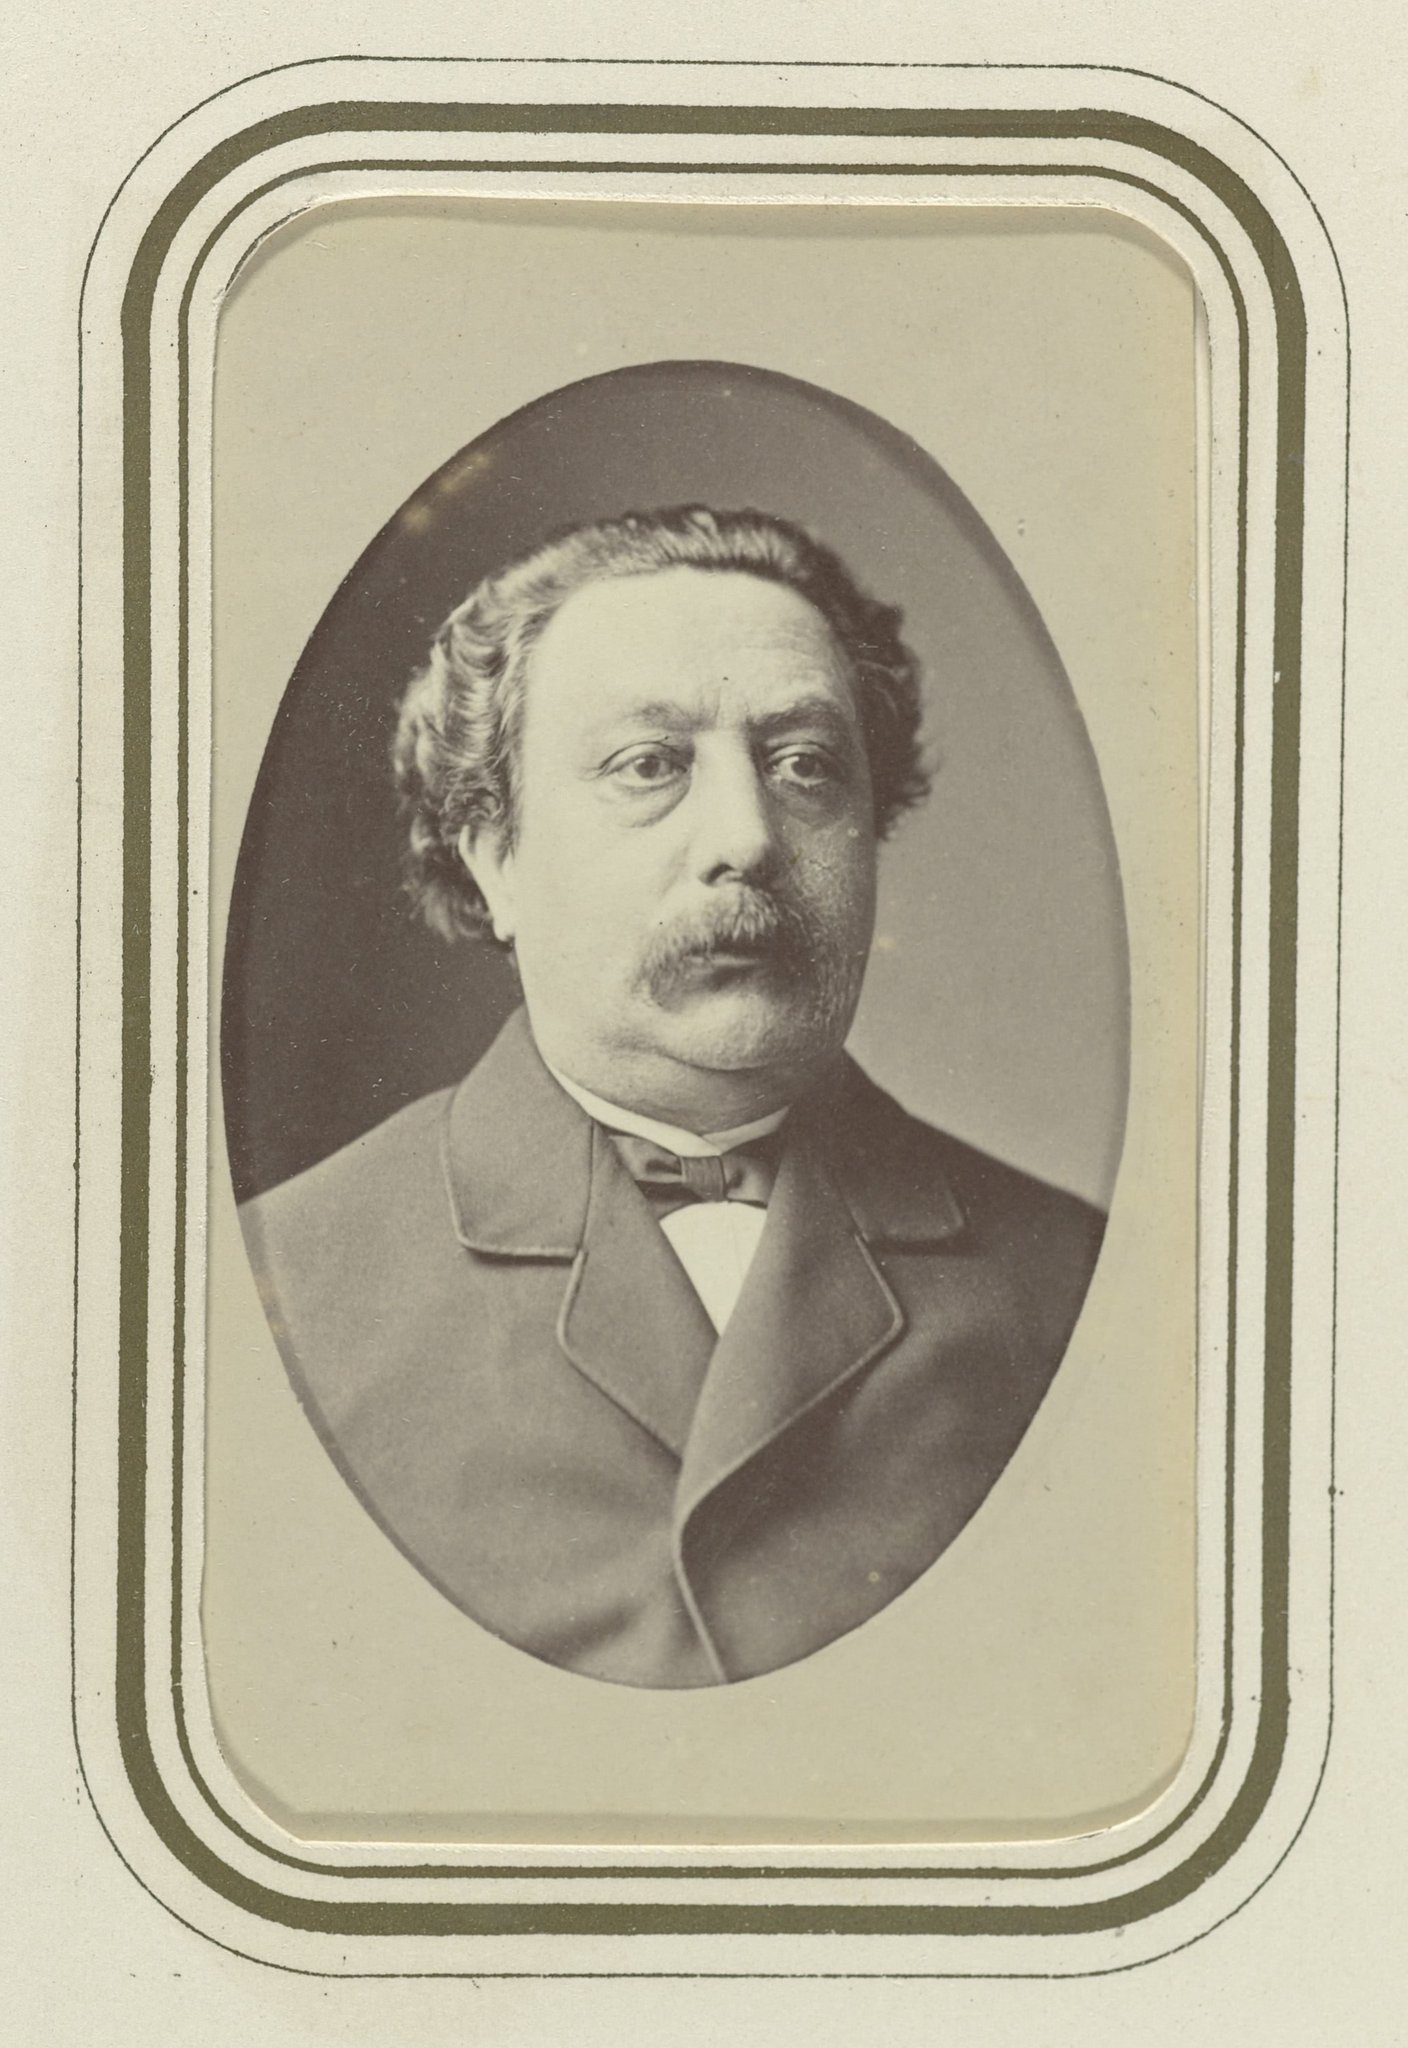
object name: carte de visite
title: Mansportret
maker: Anonymous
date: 1880-1886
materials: photographic support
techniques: photography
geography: dutch east indies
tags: anonymous historical person portrayed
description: Carte-de-visite met het portret van een onbekende man. Waarschijnlijk één van de aanbieders van het fotoalbum. Ingestoken in het fotoalbum aangeboden aan J.M. Pijnacker Hordijk bij zijn vertrek uit Jogyakarta in 1886.